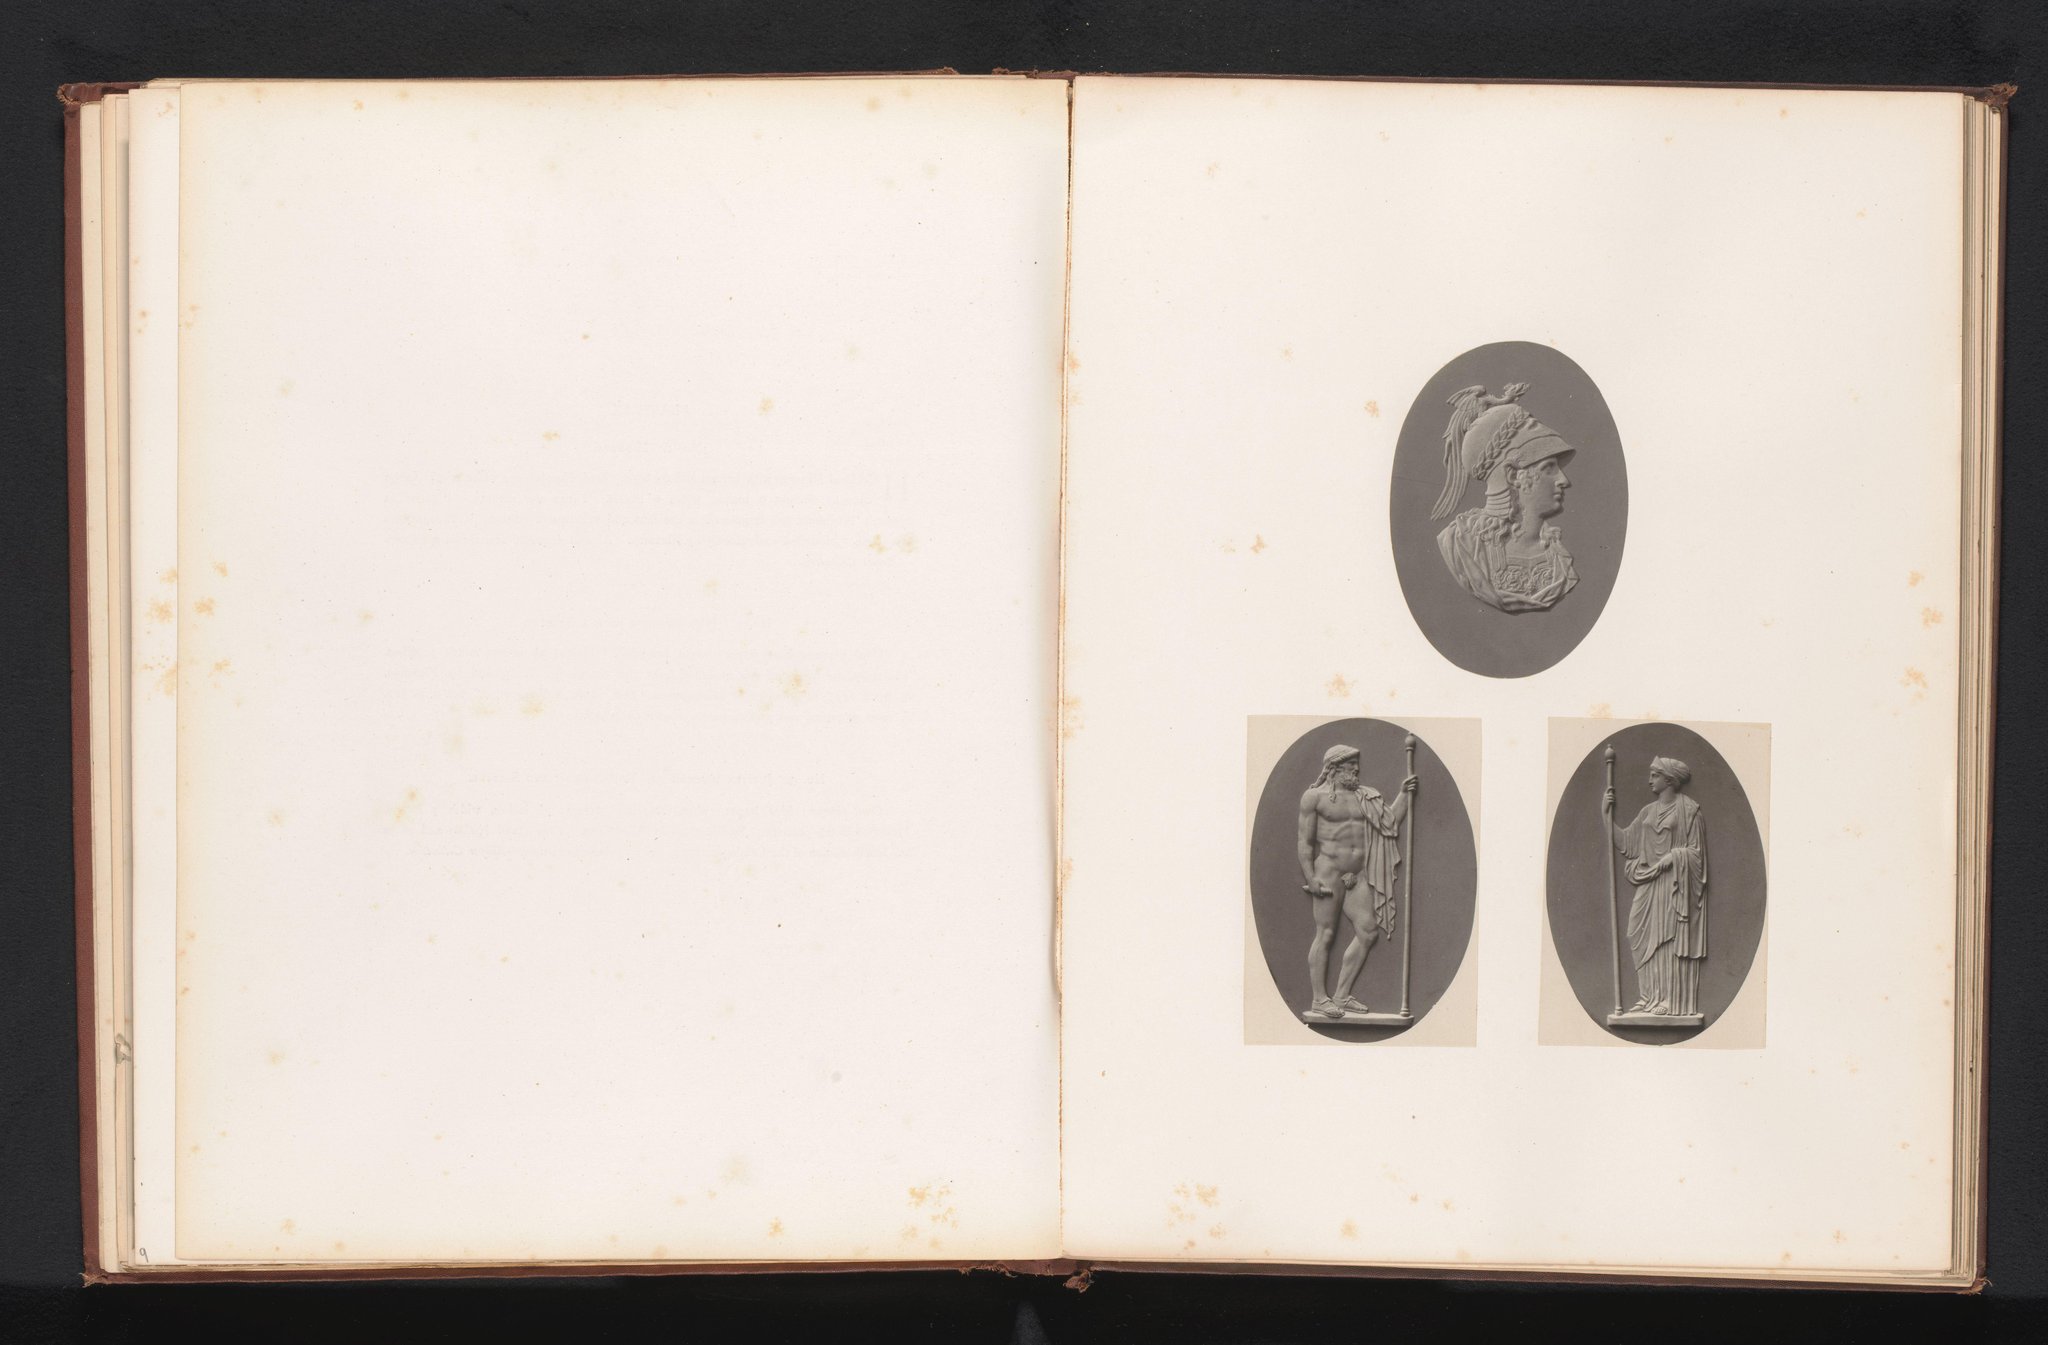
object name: photograph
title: Bas-reliëfs van Minerva, Juno met een scepter en Jupiter met bliksemschicht en een scepter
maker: joseph cundall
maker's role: fotograaf, schrijver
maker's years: 1818-1895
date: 1868-1873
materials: paper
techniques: carbon print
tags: attributes of juno, (story of) minerva (pallas, athena), attributes of jupiter, sculpture (+ relief ~ sculpture)